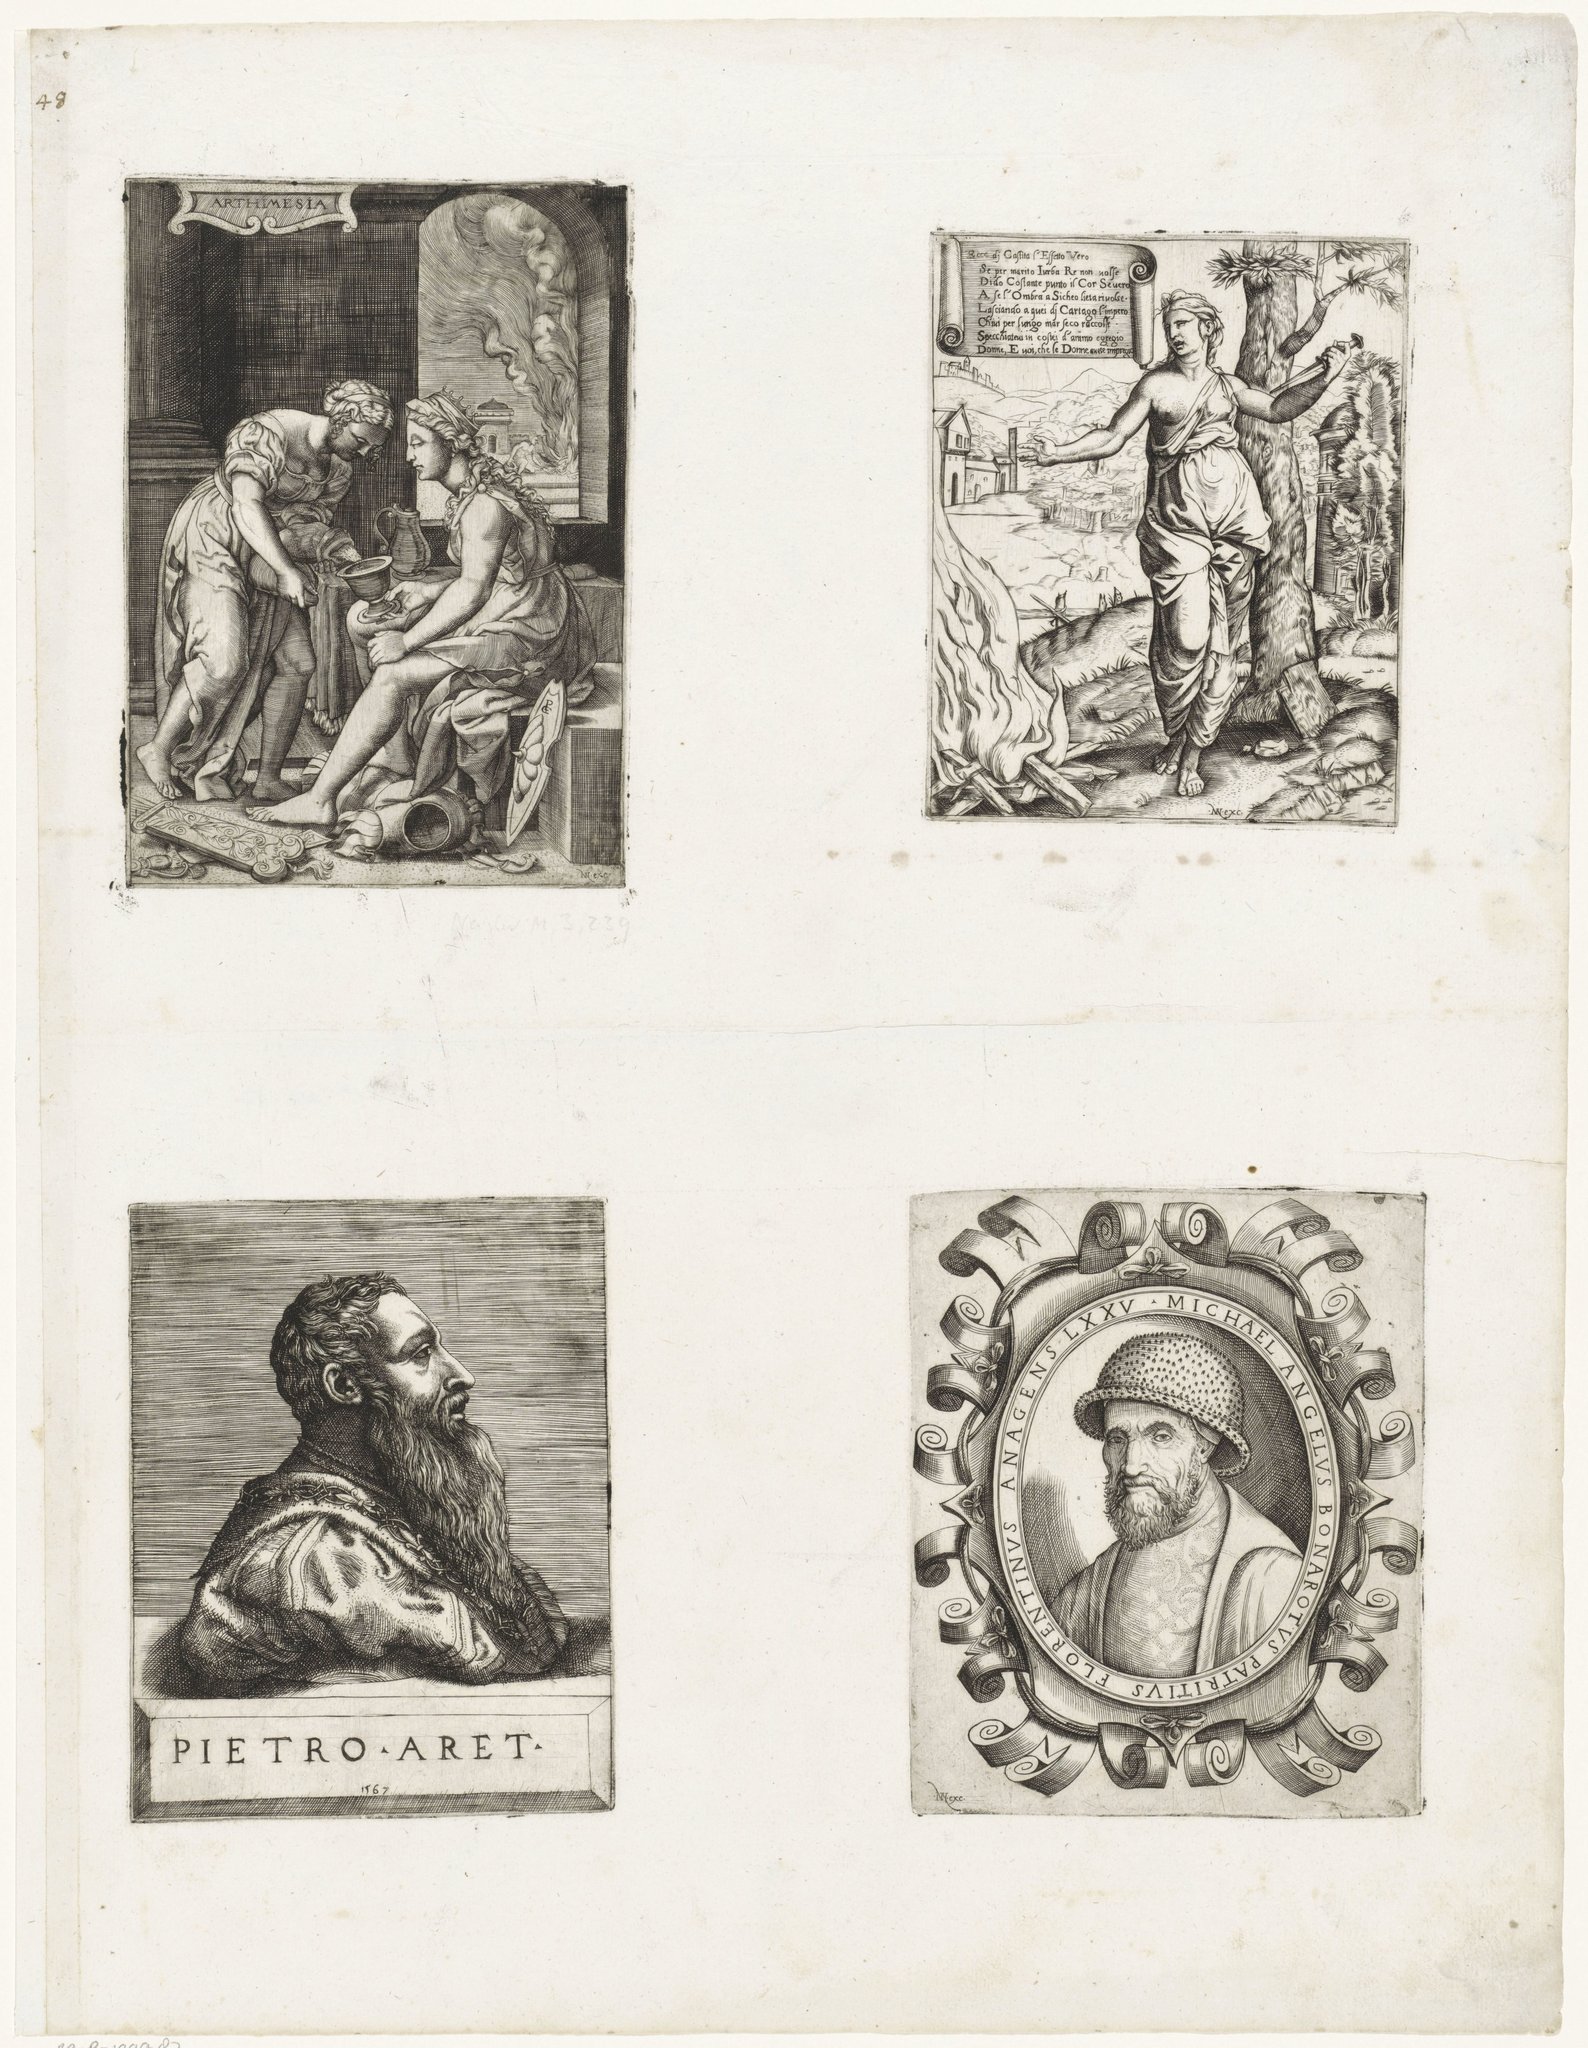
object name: print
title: Artemisia, Dido, Pietro Aretino,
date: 1567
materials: paper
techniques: engraving, etching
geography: germany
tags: rome, painter, draughtsman, sculptor, michelangelo, venice, artemisia with the urn containing the ashes of mausolus, death of lucretia: she commits suicide by stabbing herself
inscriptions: number: ‘48’, watermark, collector's mark: Lugt 2228, collector's mark: Lugt 2760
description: In order to waste as little paper as possible, multiple copper plates were often printed on a single sheet. The sheets were then cut and the prints sold individually. Zobel must have acquired this sheet with four different small prints when the impression had just been pulled from the press, for he included it, uncut, in his album.